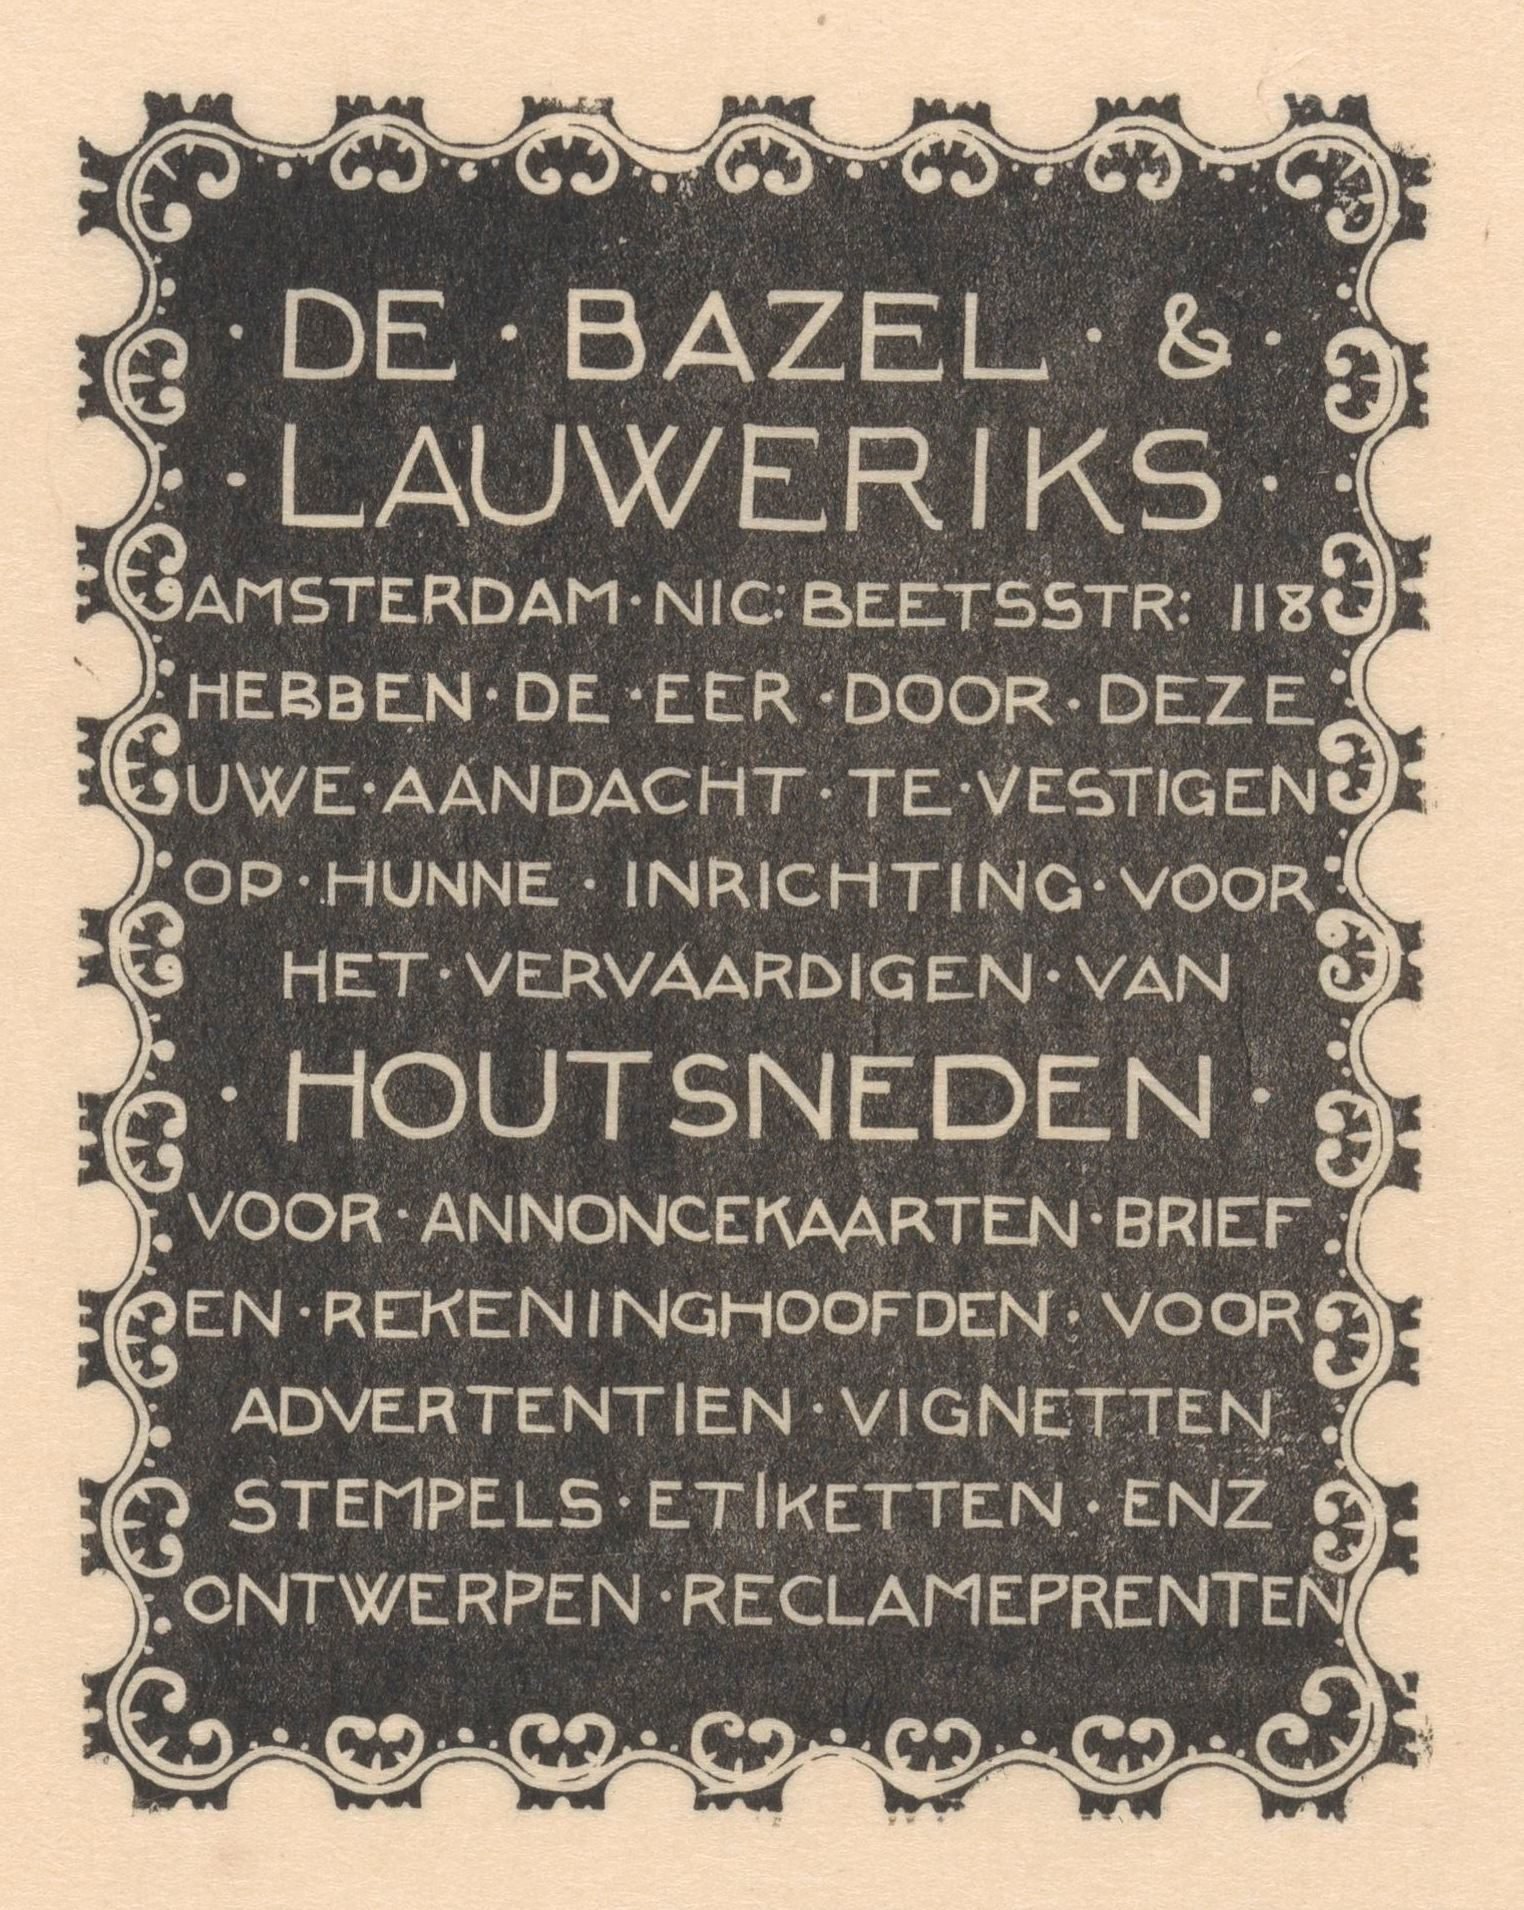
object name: print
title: Aankondiging lezingen van A. Besant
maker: mathieu lauweriks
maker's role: designer, draughtsman, print maker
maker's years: 1864-1932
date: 1903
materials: paper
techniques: woodcut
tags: snakes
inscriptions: collector's mark: Lugt 2228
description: Aankondiging van twee lezingen van mevrouw A. Besant bij het hoofdkwartier van de Nederlandse theosofische vereniging aan de Amsteldijk 34 in Amsterdam. Links en rechts een slang.